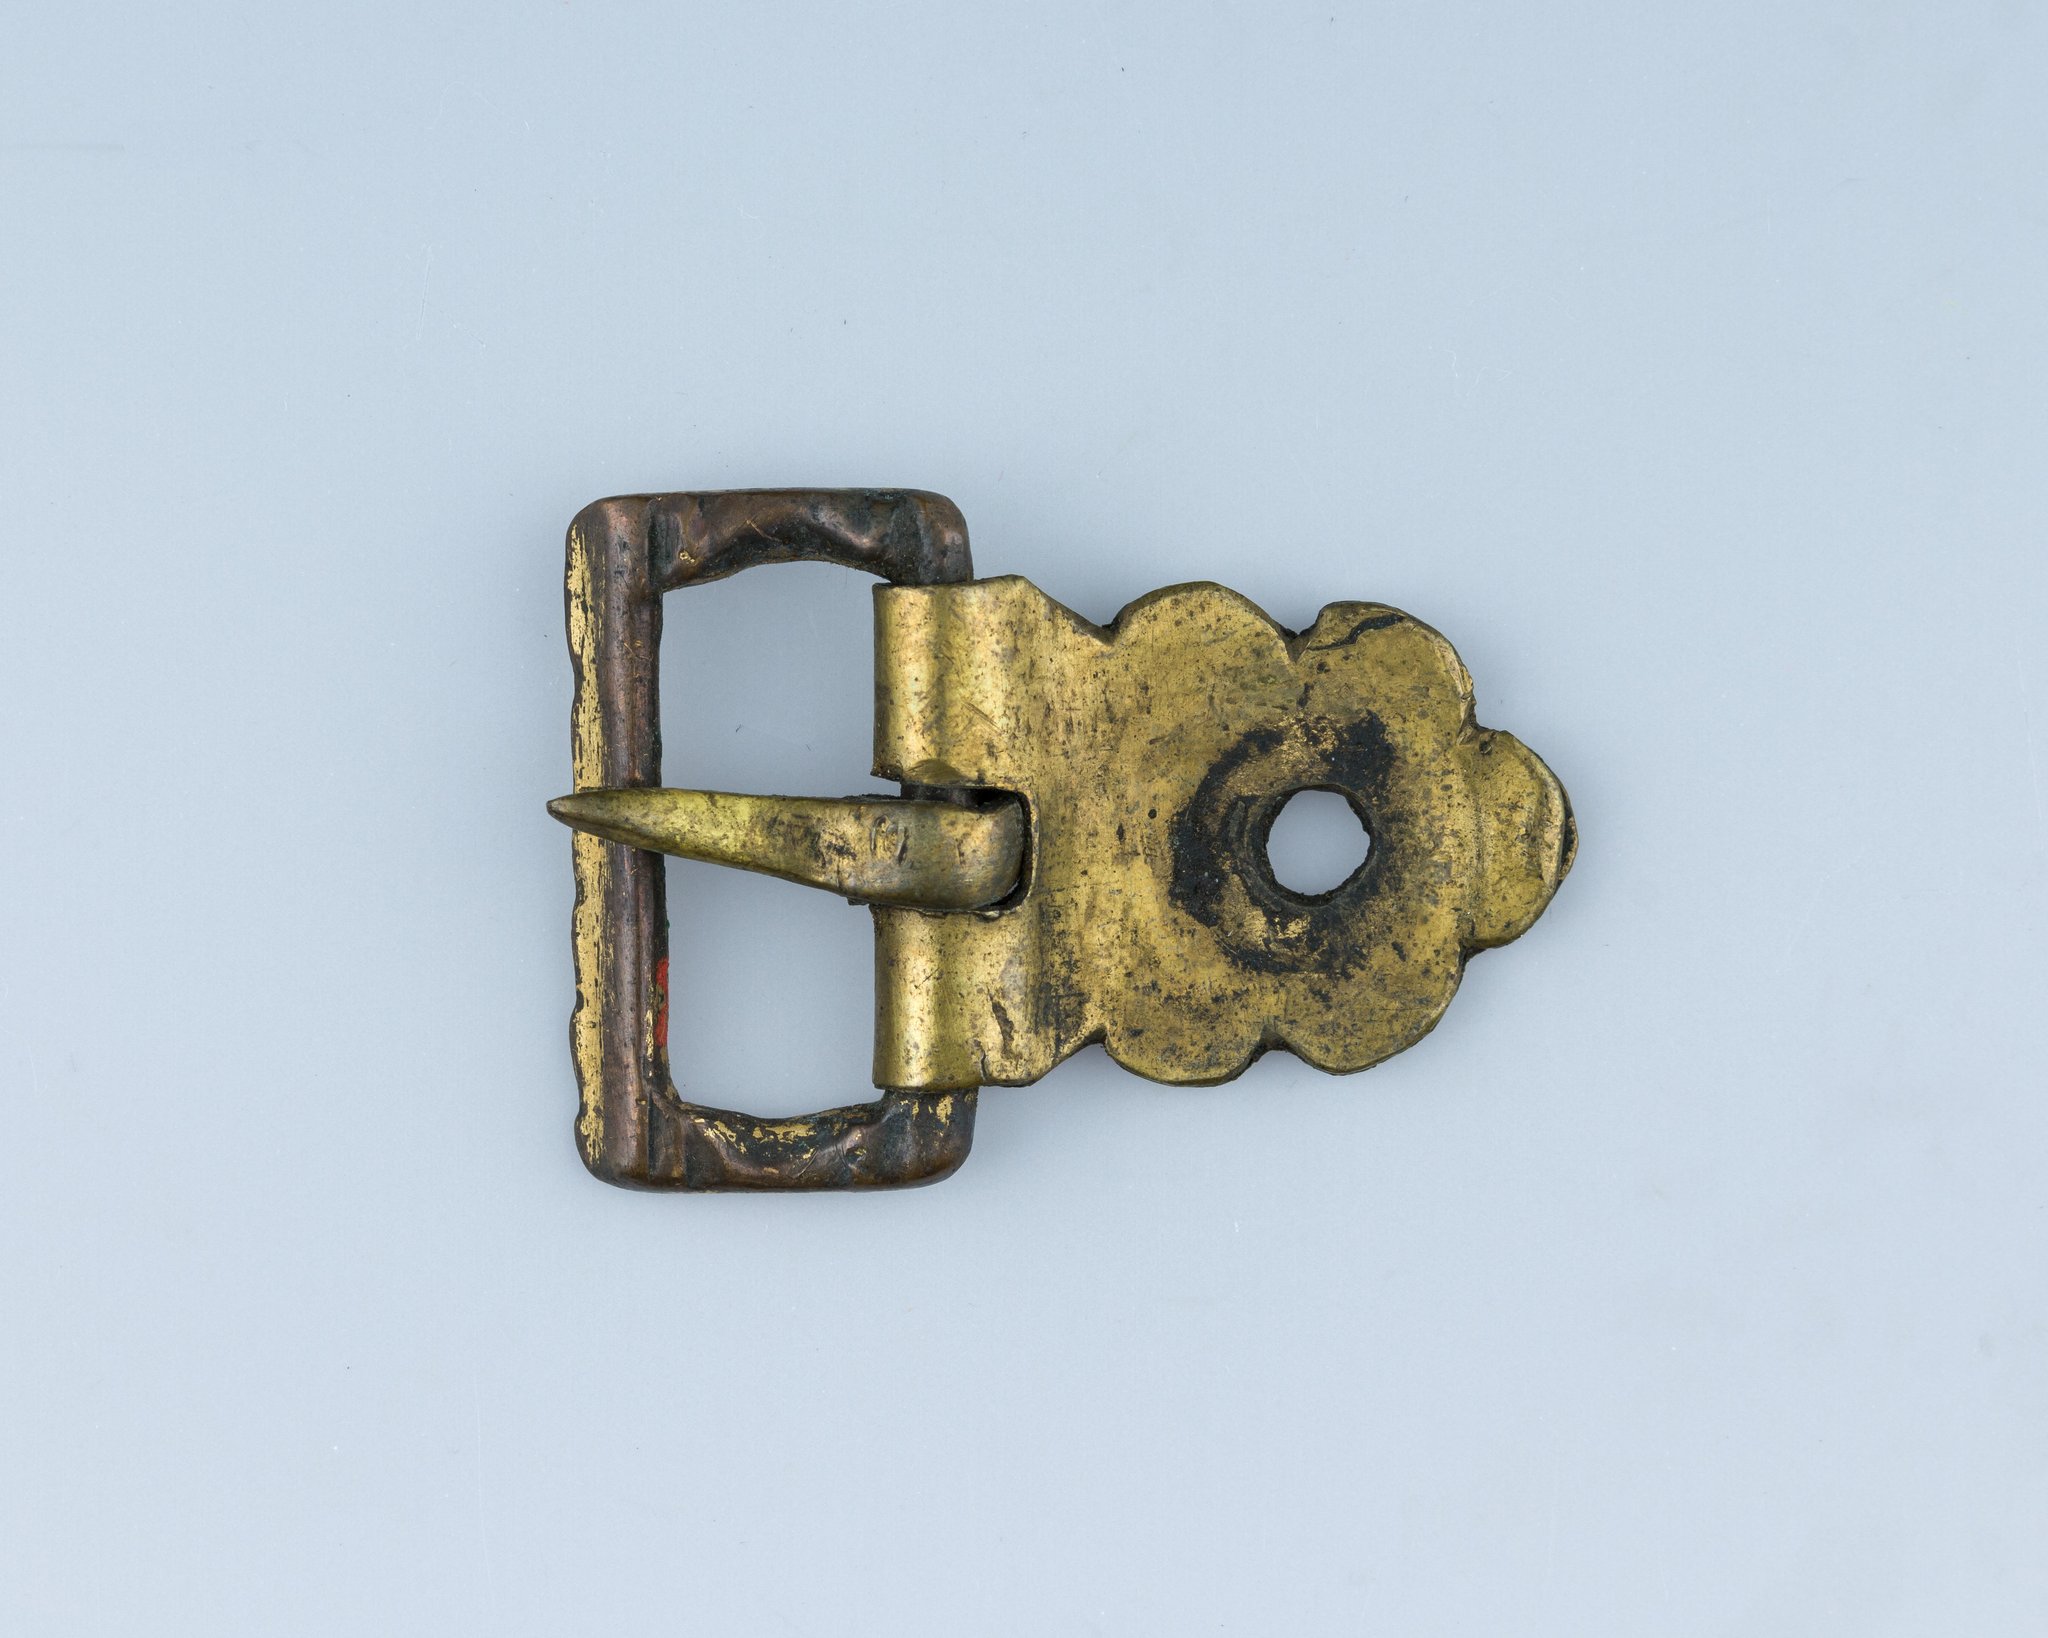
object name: buckle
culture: german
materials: brass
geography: germany